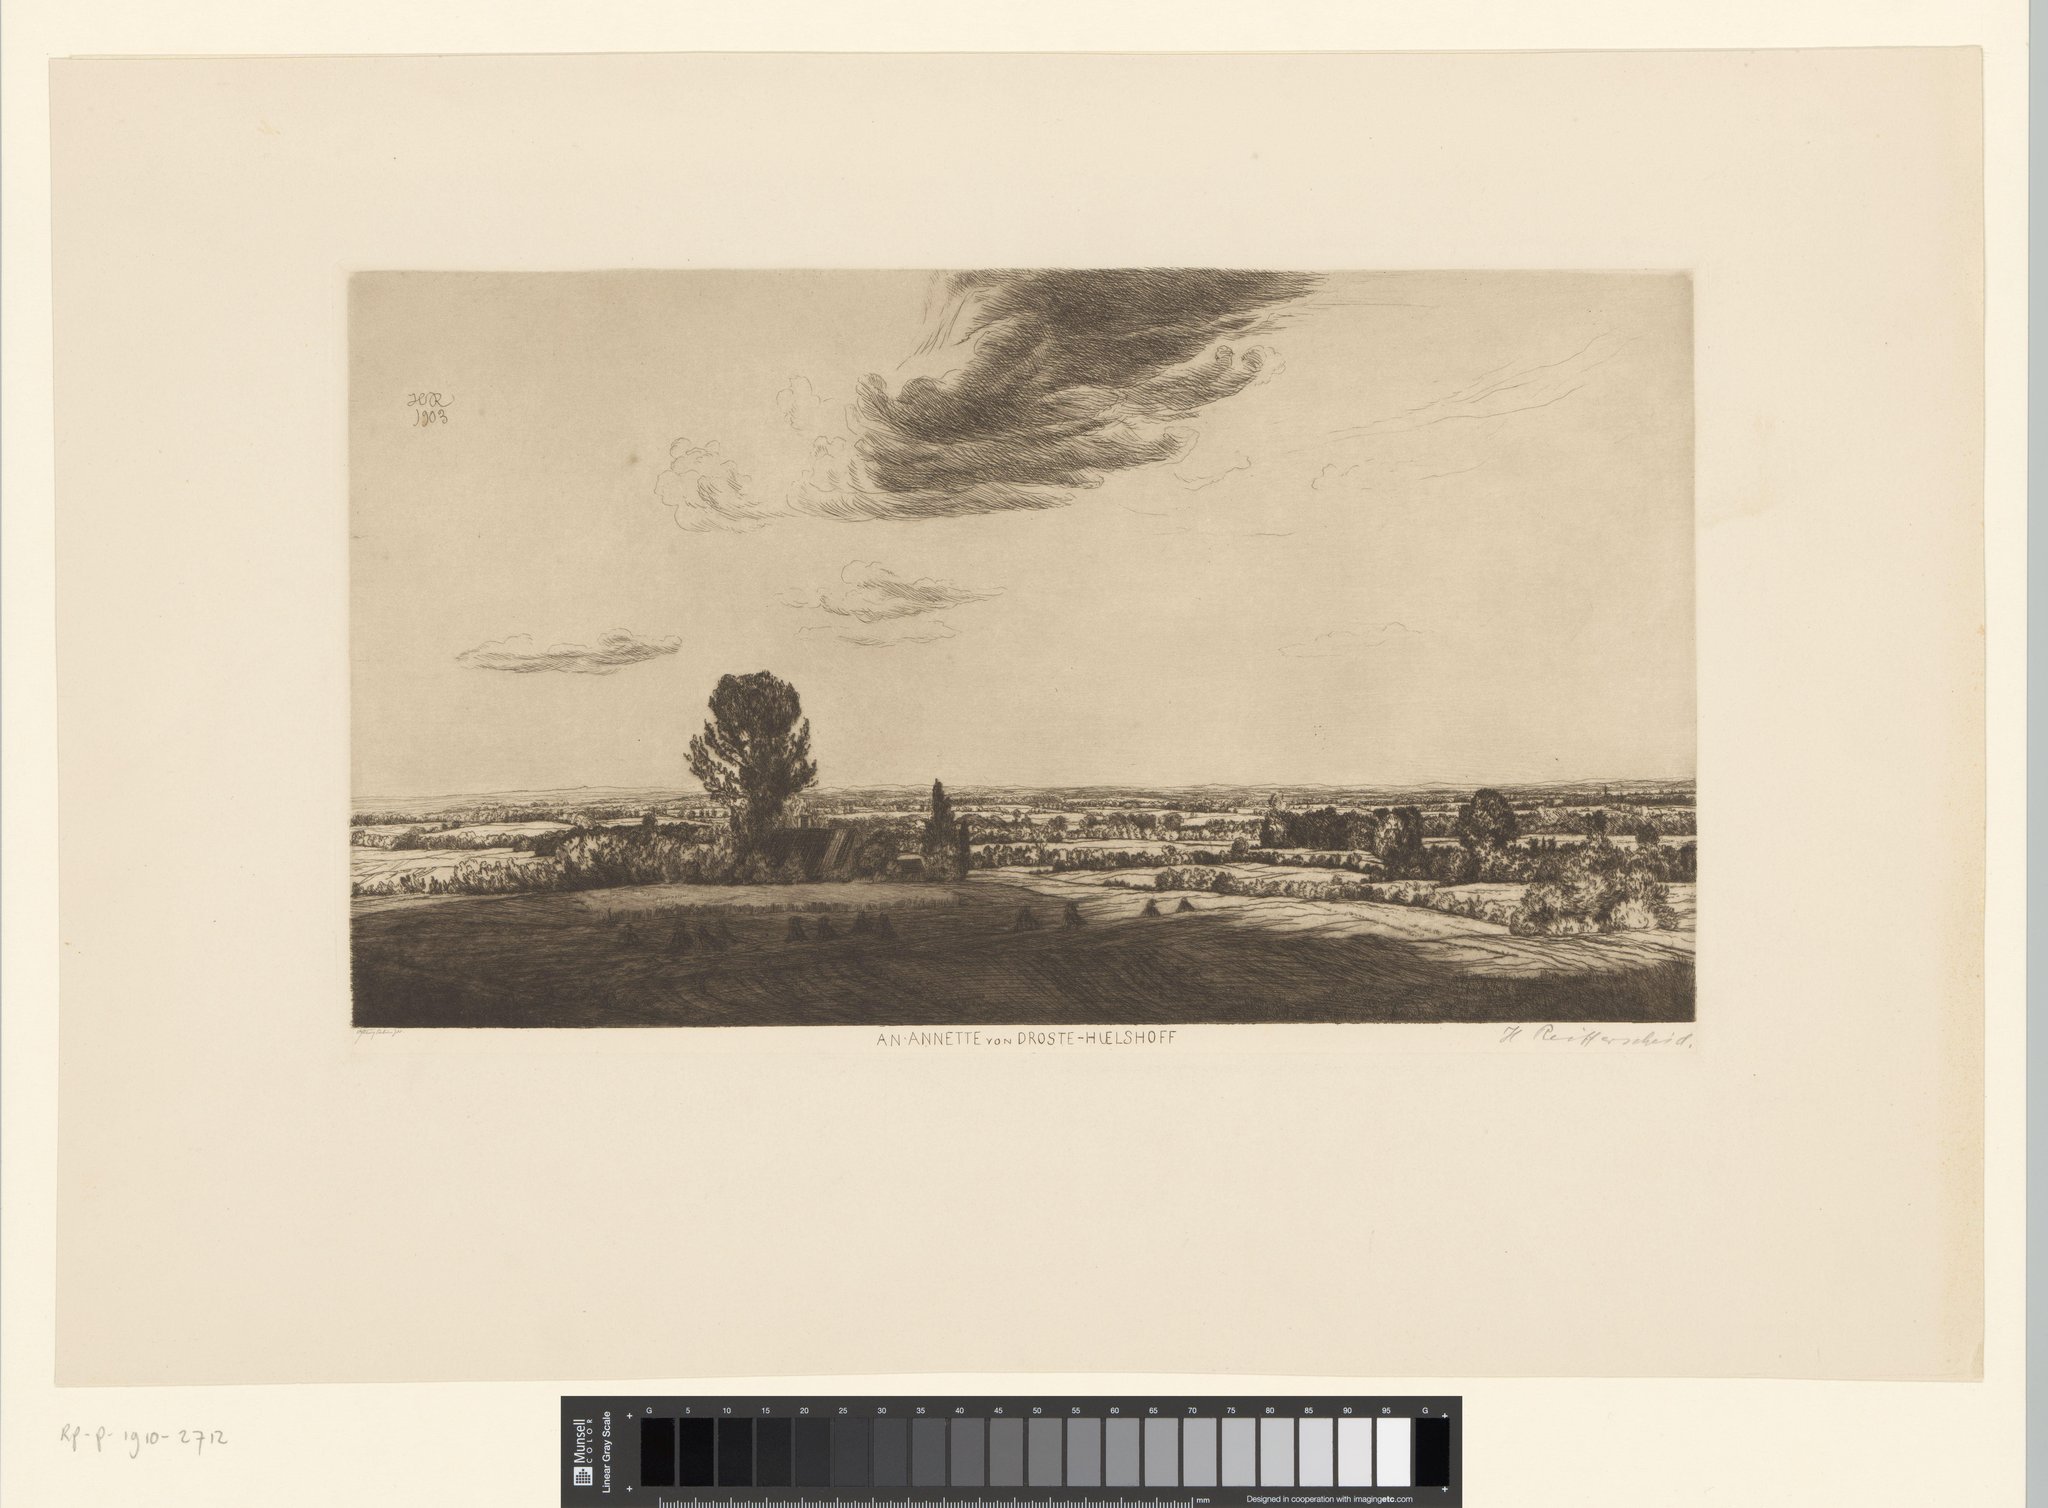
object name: print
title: Landschap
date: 1882-1910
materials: paper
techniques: etching, intaglio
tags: landscapes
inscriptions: collector's mark: Lugt 2228, signature